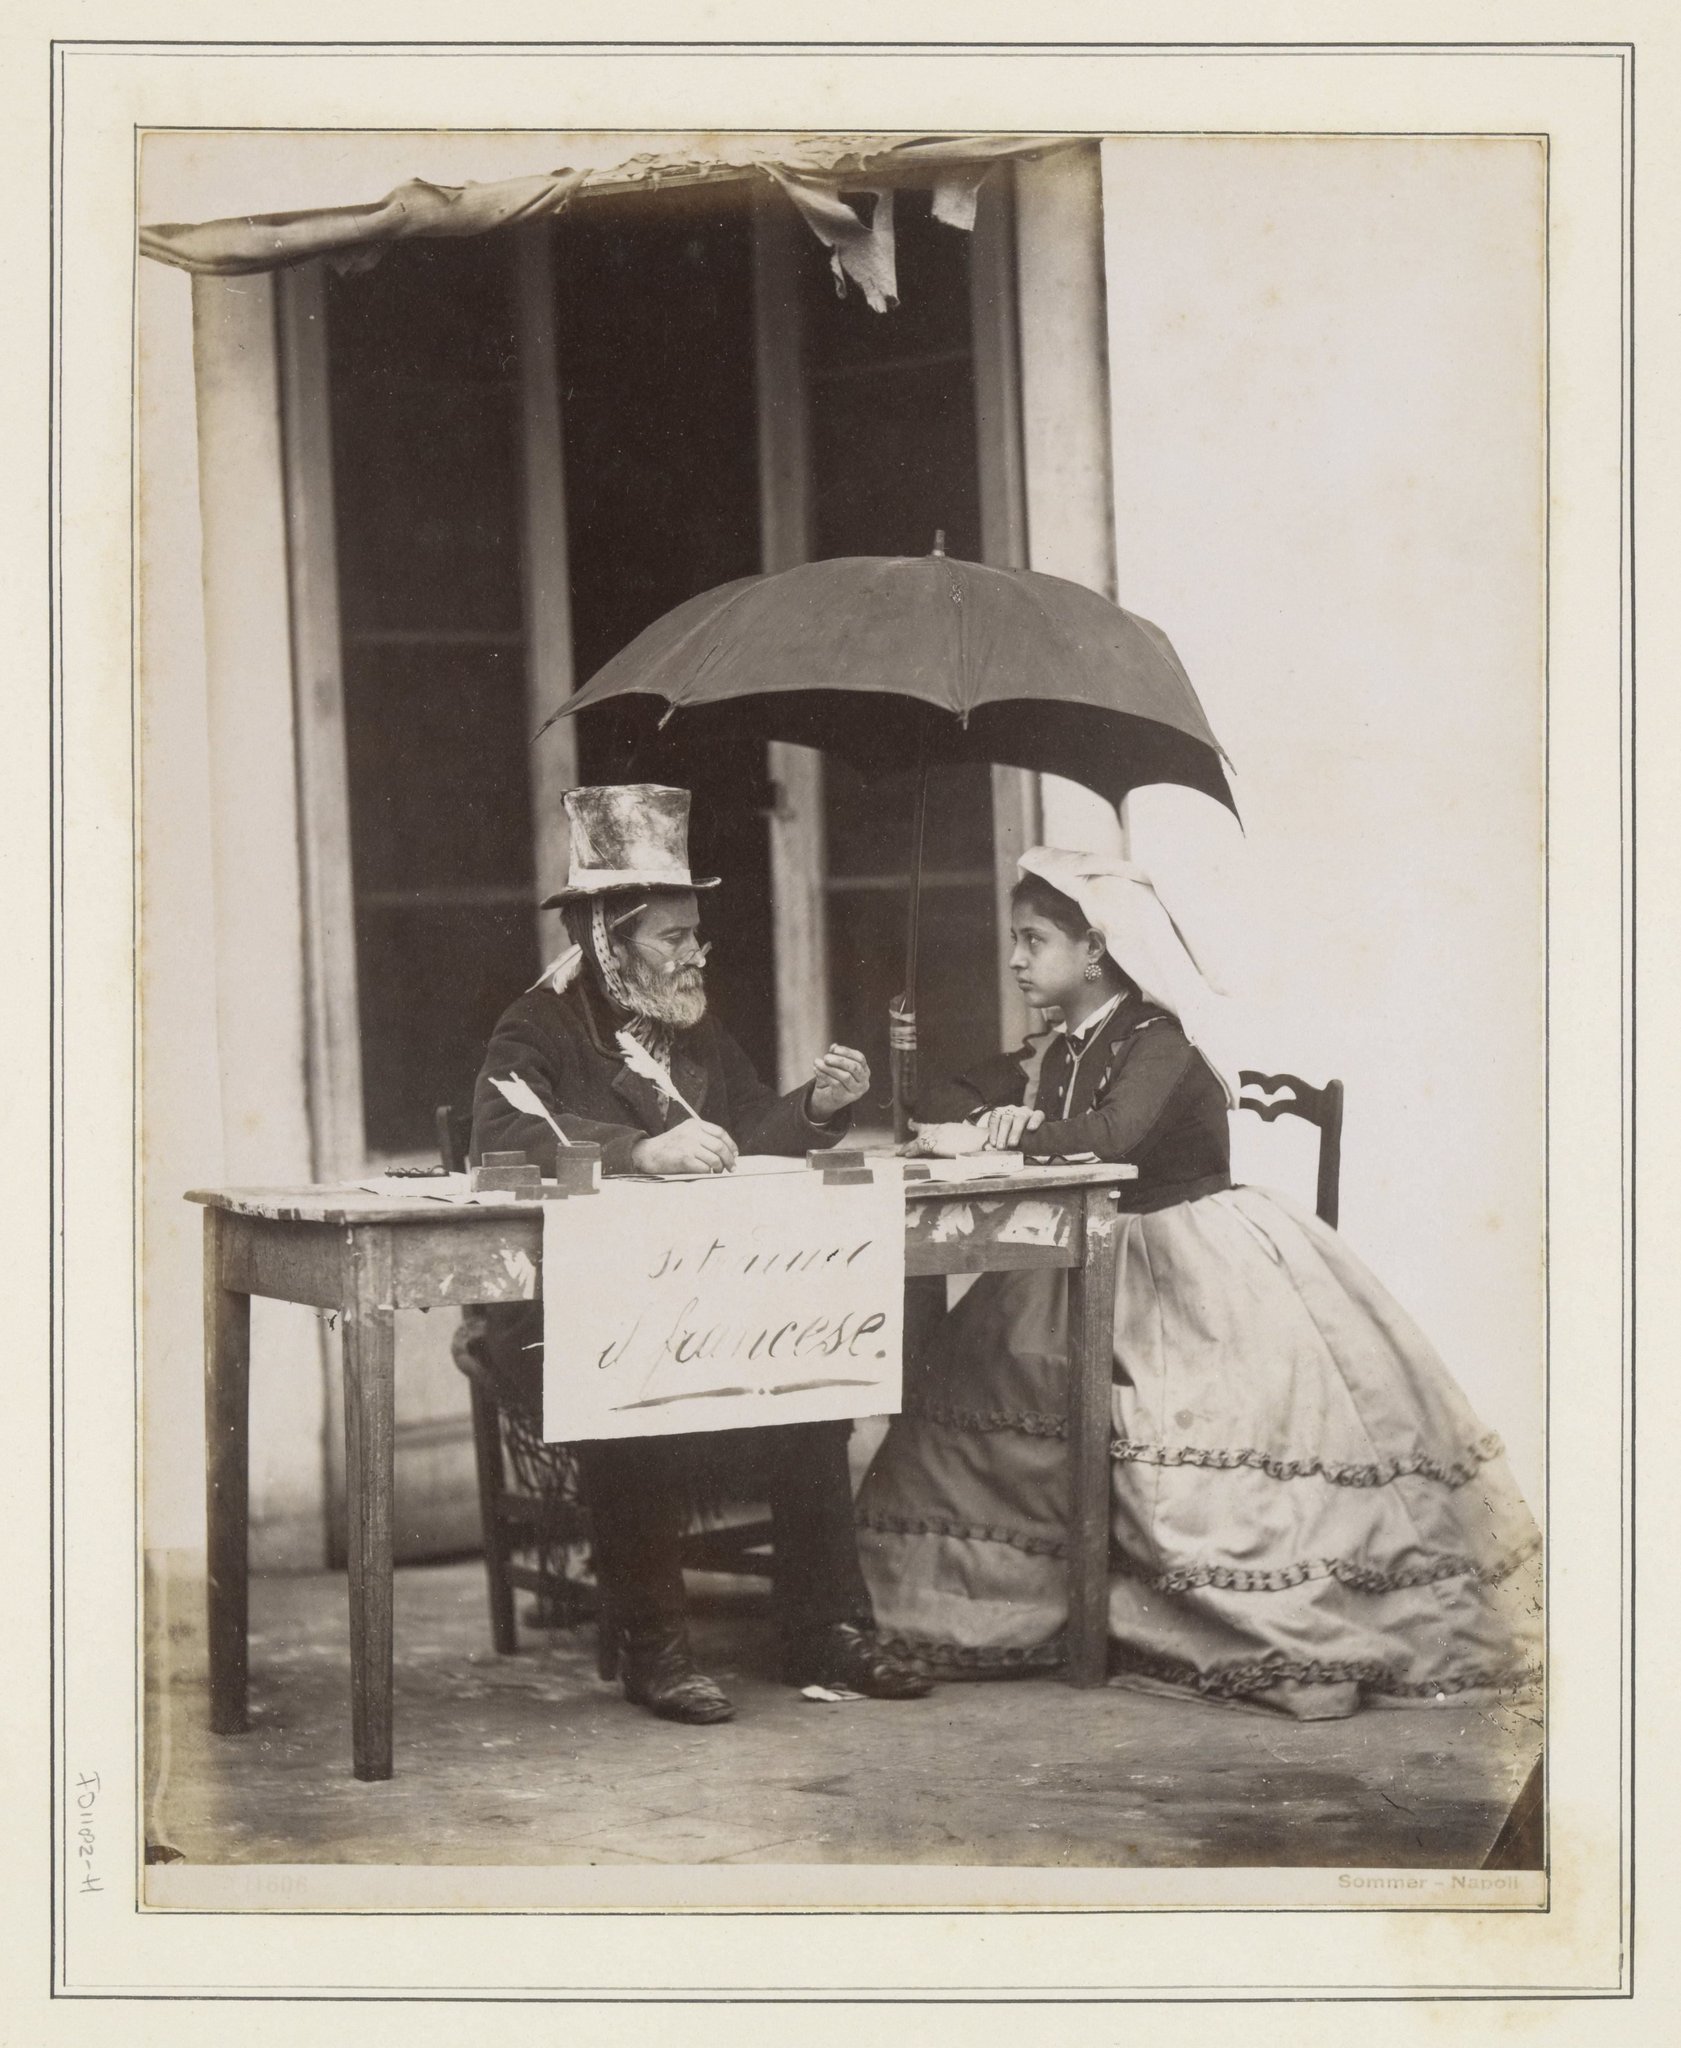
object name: photograph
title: Schrijver met jonge vrouw aan tafel op straat in Italië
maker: giorgio sommer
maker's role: fotograaf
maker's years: 1834-1914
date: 1870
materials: paper, photographic support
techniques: albumen print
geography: italy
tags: handwriting, writing as activity, italy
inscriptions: negative number: ‘11606’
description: Onderdeel van Reisalbum met foto's van bezienswaardigheden in Italië en aan de Franse Rivièra (deel II).